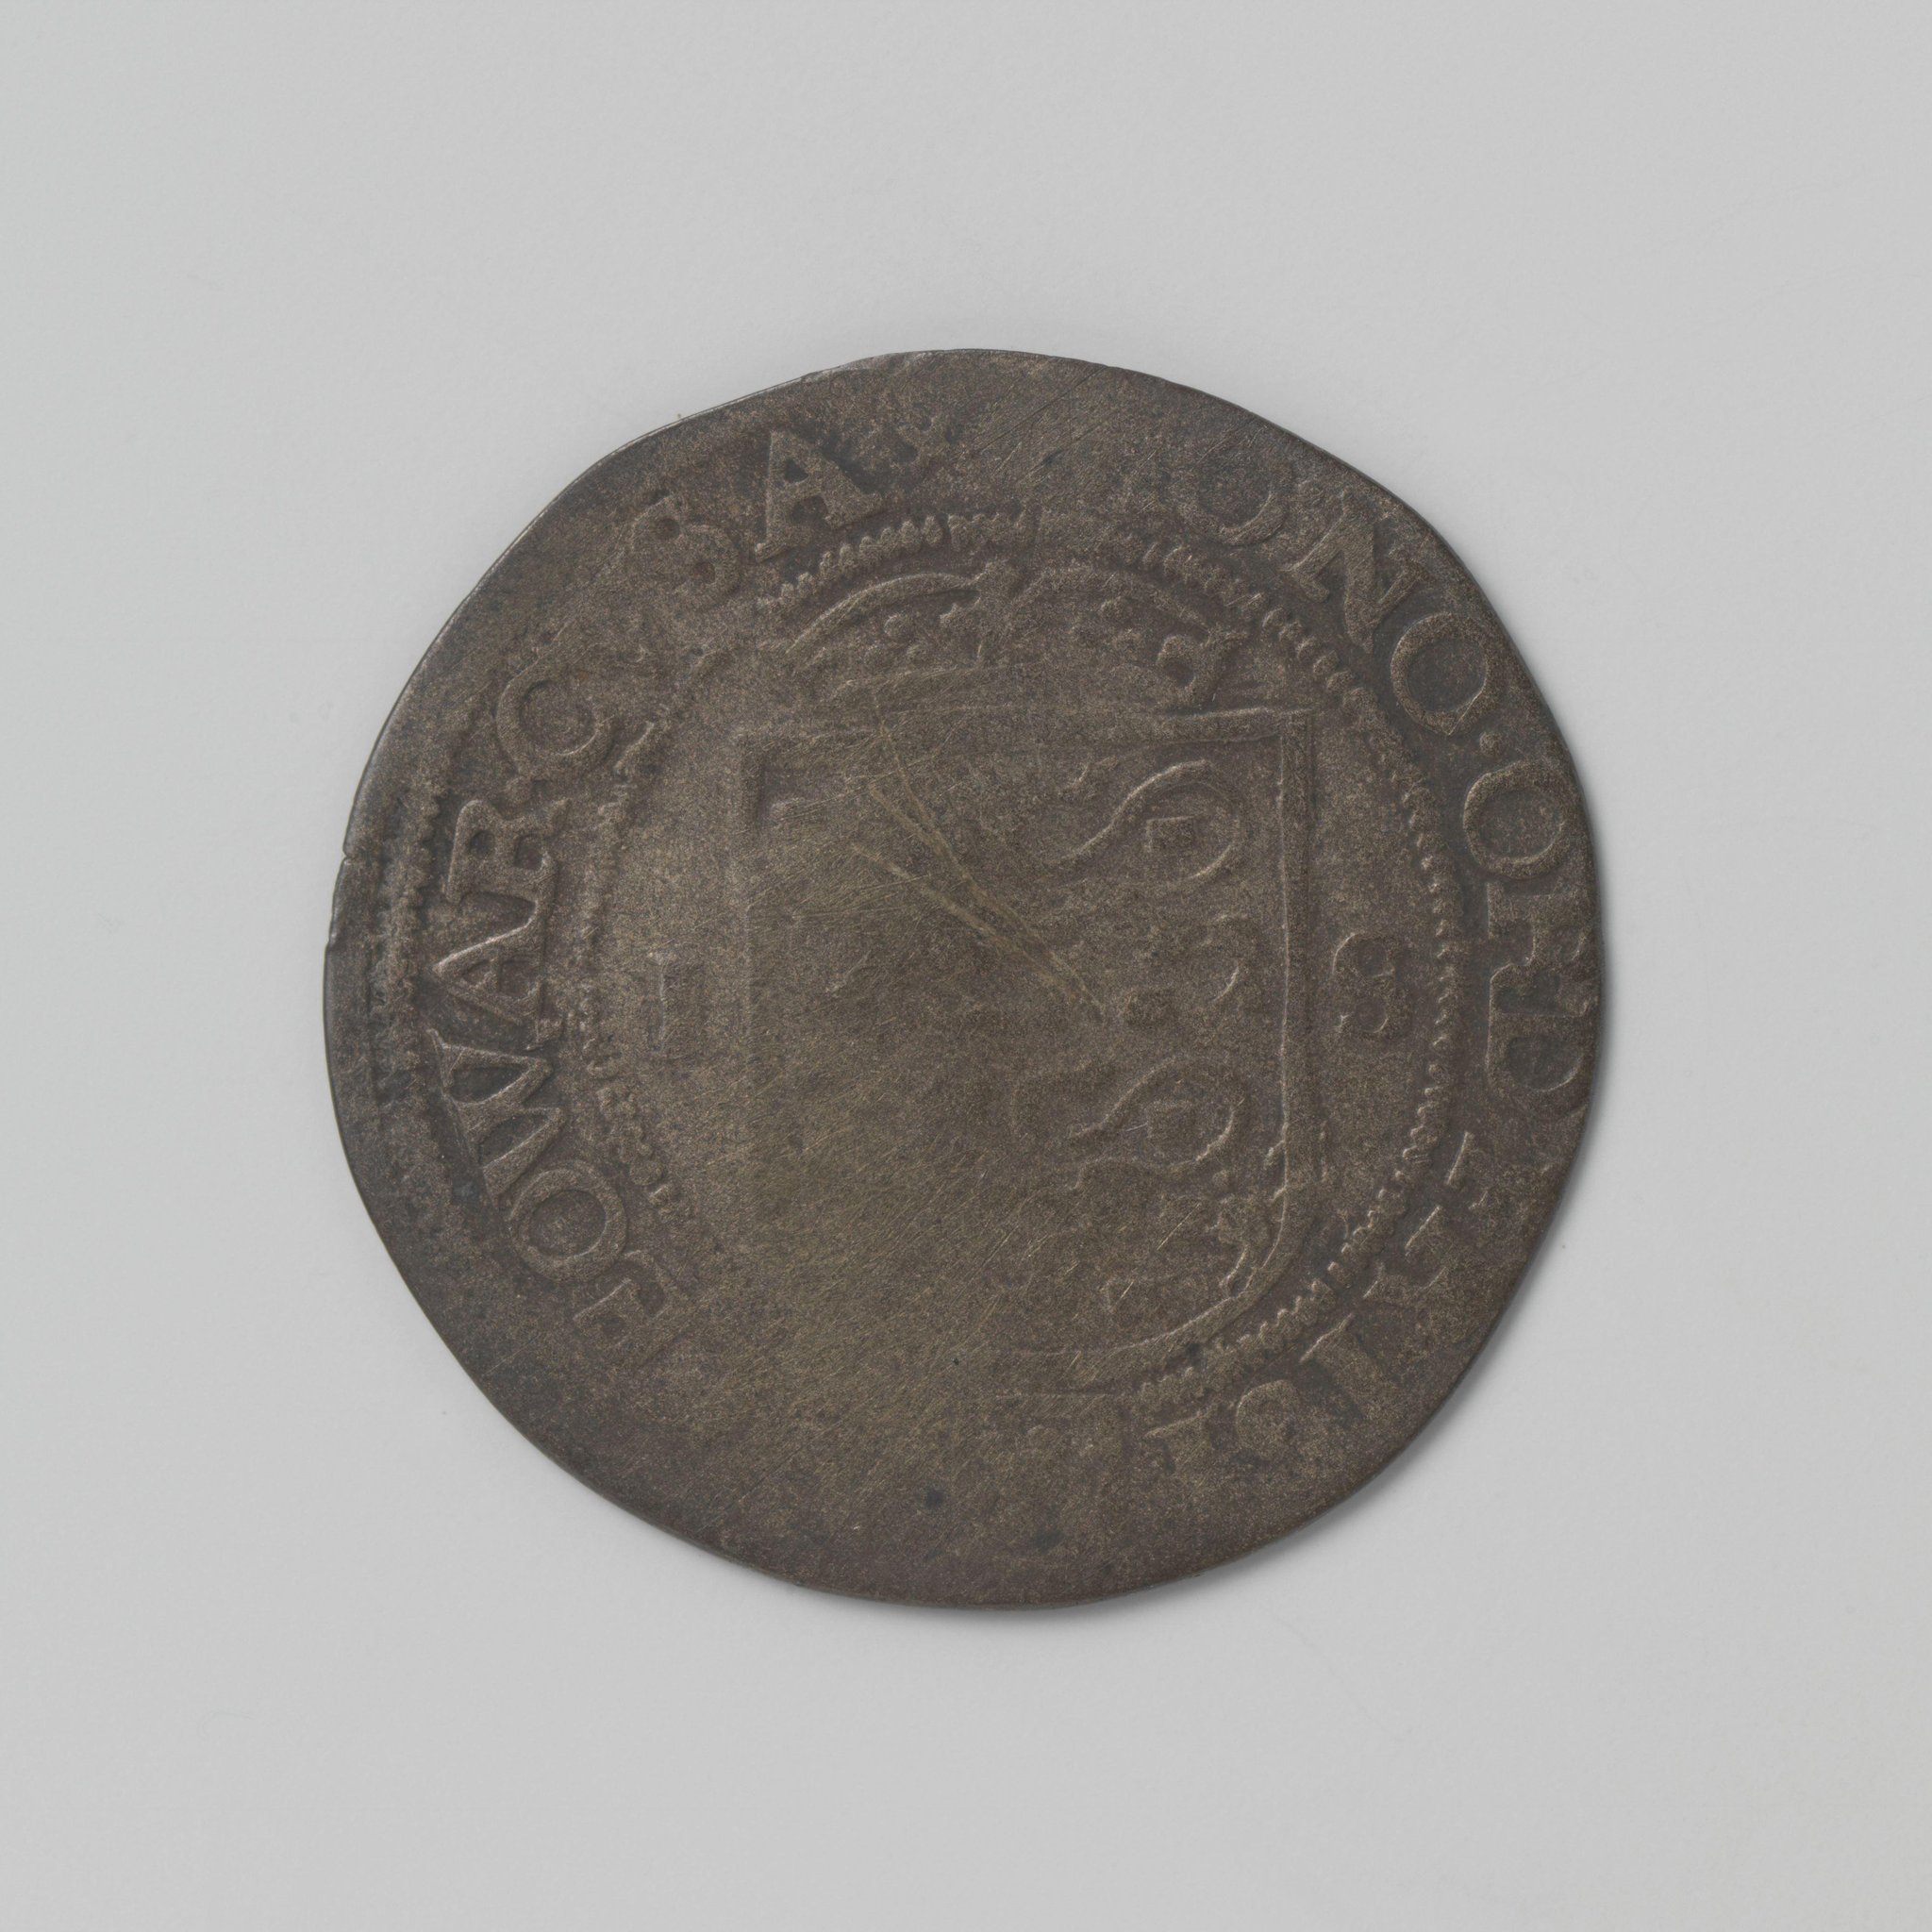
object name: stuiver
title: Friesland, stuiver, 1581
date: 1581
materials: silver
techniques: striking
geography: leeuwarden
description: Zilveren munt. Voorzijde: tussen waarde-aanduiding gekroond wapenschild van Friesland. In omschrift jaartal. Keerzijde: op vierpas lang versierd kruis met in het hart wapenschild met leeuwtje. In omschrift aanduiding muntplaats.